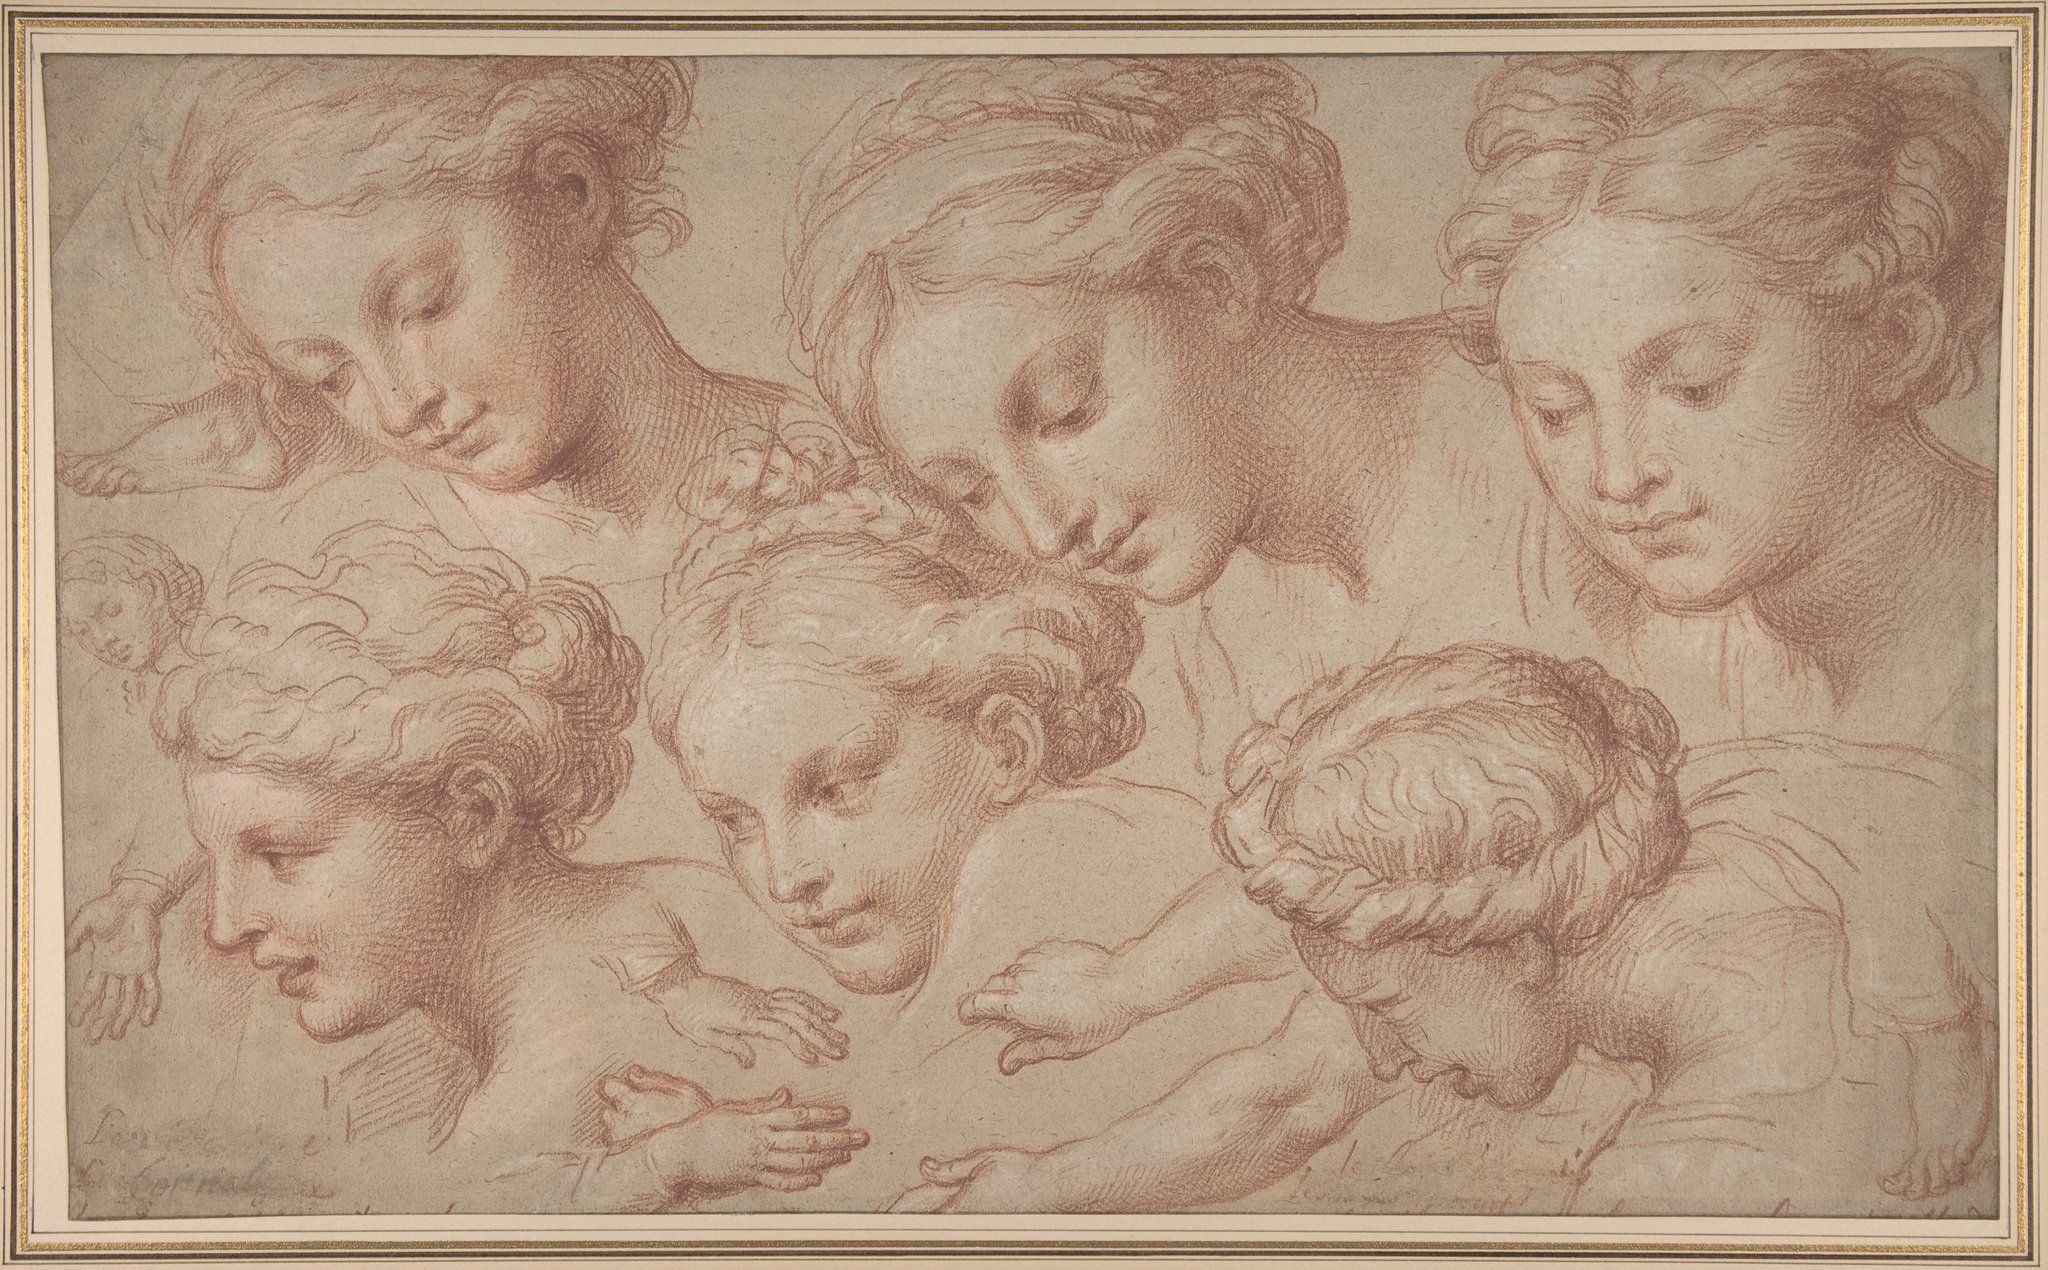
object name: drawing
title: Copies after Raphael's 'The Finding of Moses'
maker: michel corneille the younger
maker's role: artist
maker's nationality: french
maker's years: 1642-1708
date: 1660-1710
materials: chalk, pastel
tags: women,moses